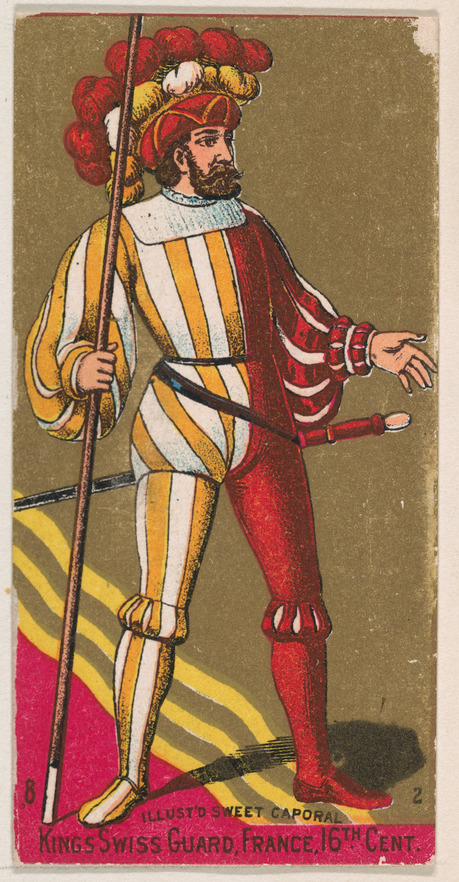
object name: print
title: Kings Swiss Guard, France, 16th Century, from the Military Series (N224) issued by Kinney Tobacco Company to promote Sweet Caporal Cigarettes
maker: kinney brothers tobacco company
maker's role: publisher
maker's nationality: american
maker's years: 1869-2011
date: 1888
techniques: color lithograph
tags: soldiers,men